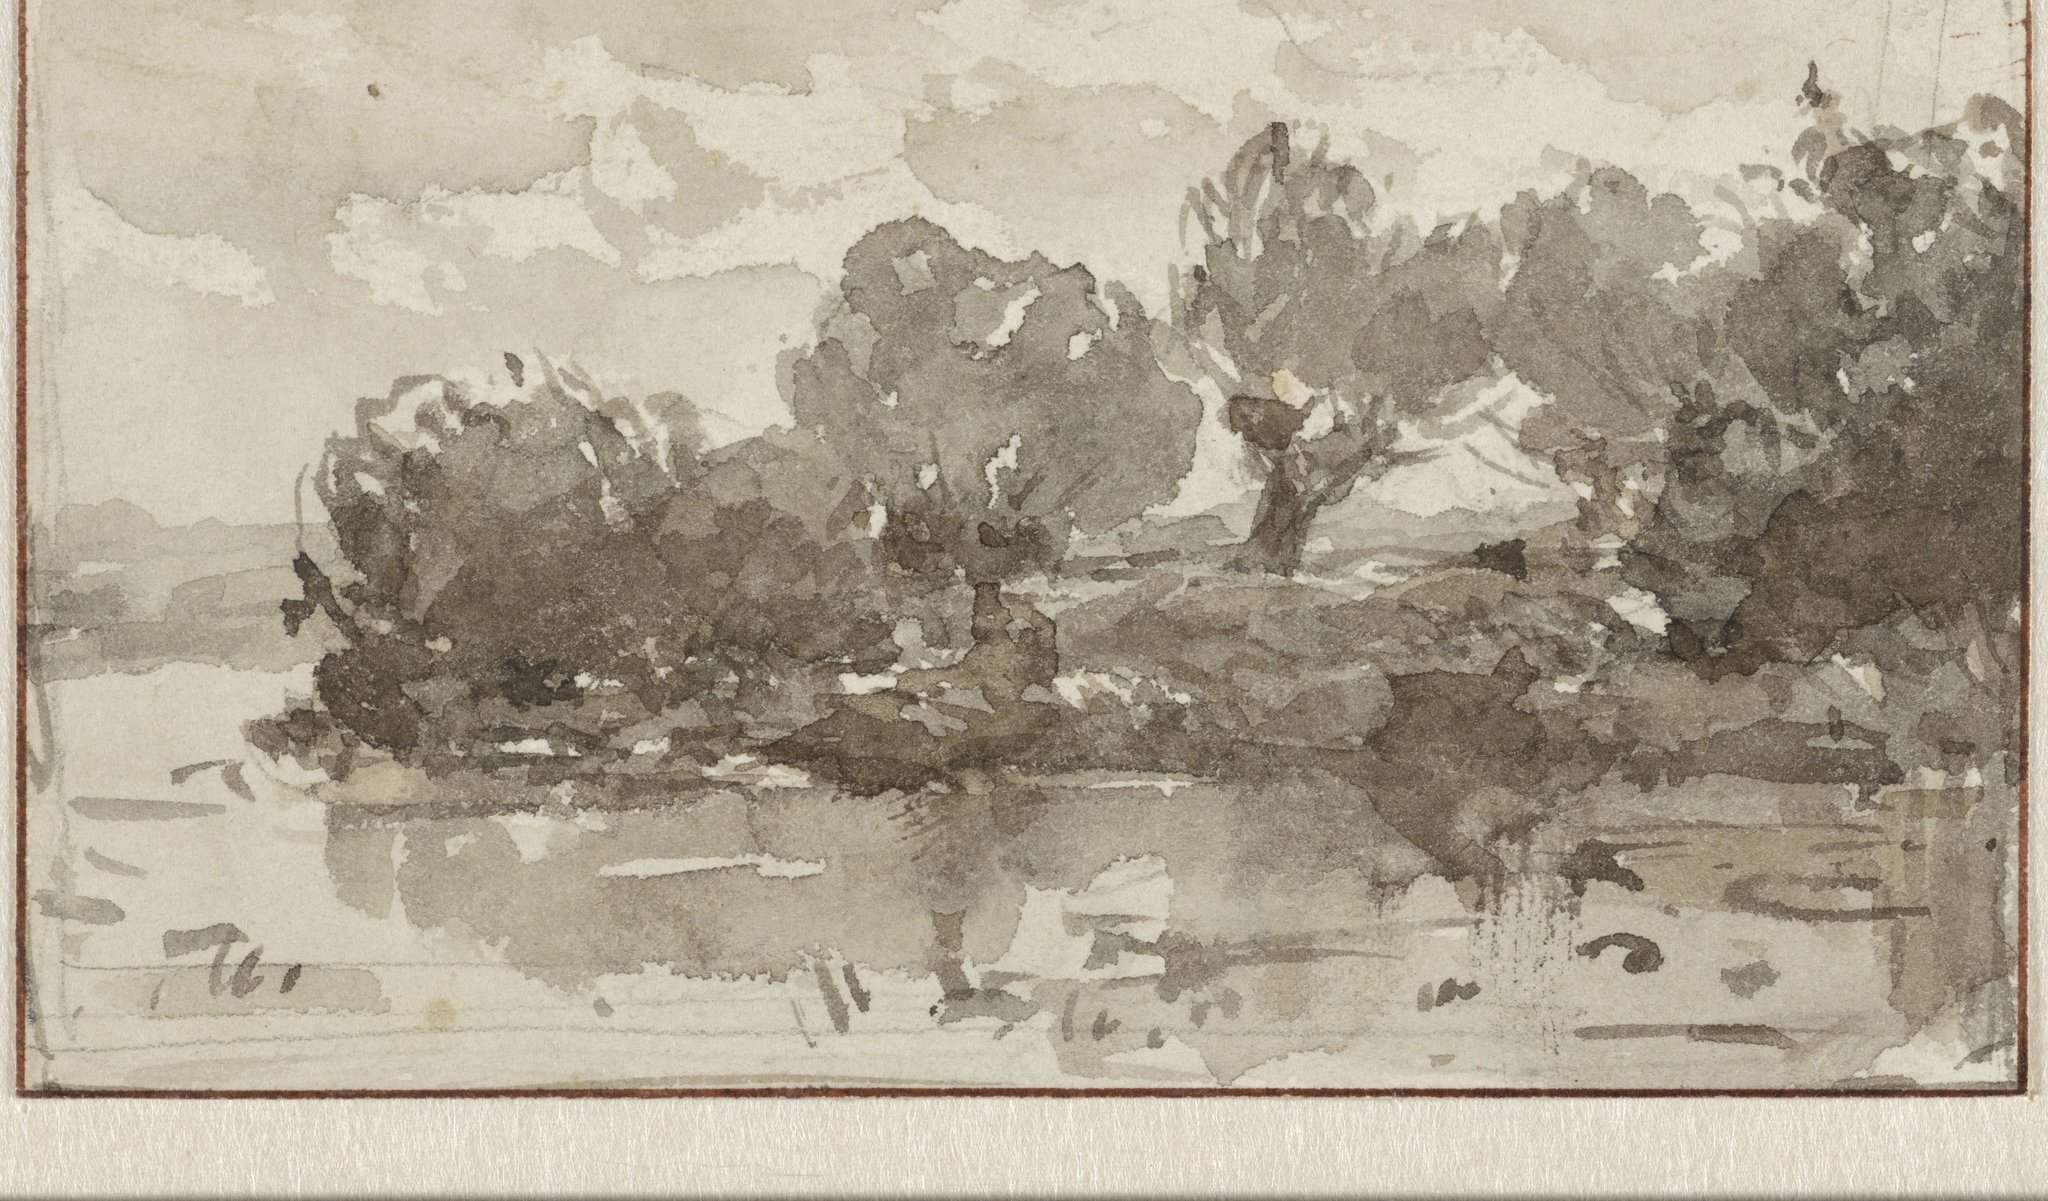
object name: drawing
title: Knotwilligen aan de waterkant te Loosdrecht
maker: willem roelofs (i)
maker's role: draughtsman, painter, print maker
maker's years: 1822-1897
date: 1889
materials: paper, pencil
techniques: brush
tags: trees: pollard willow, river